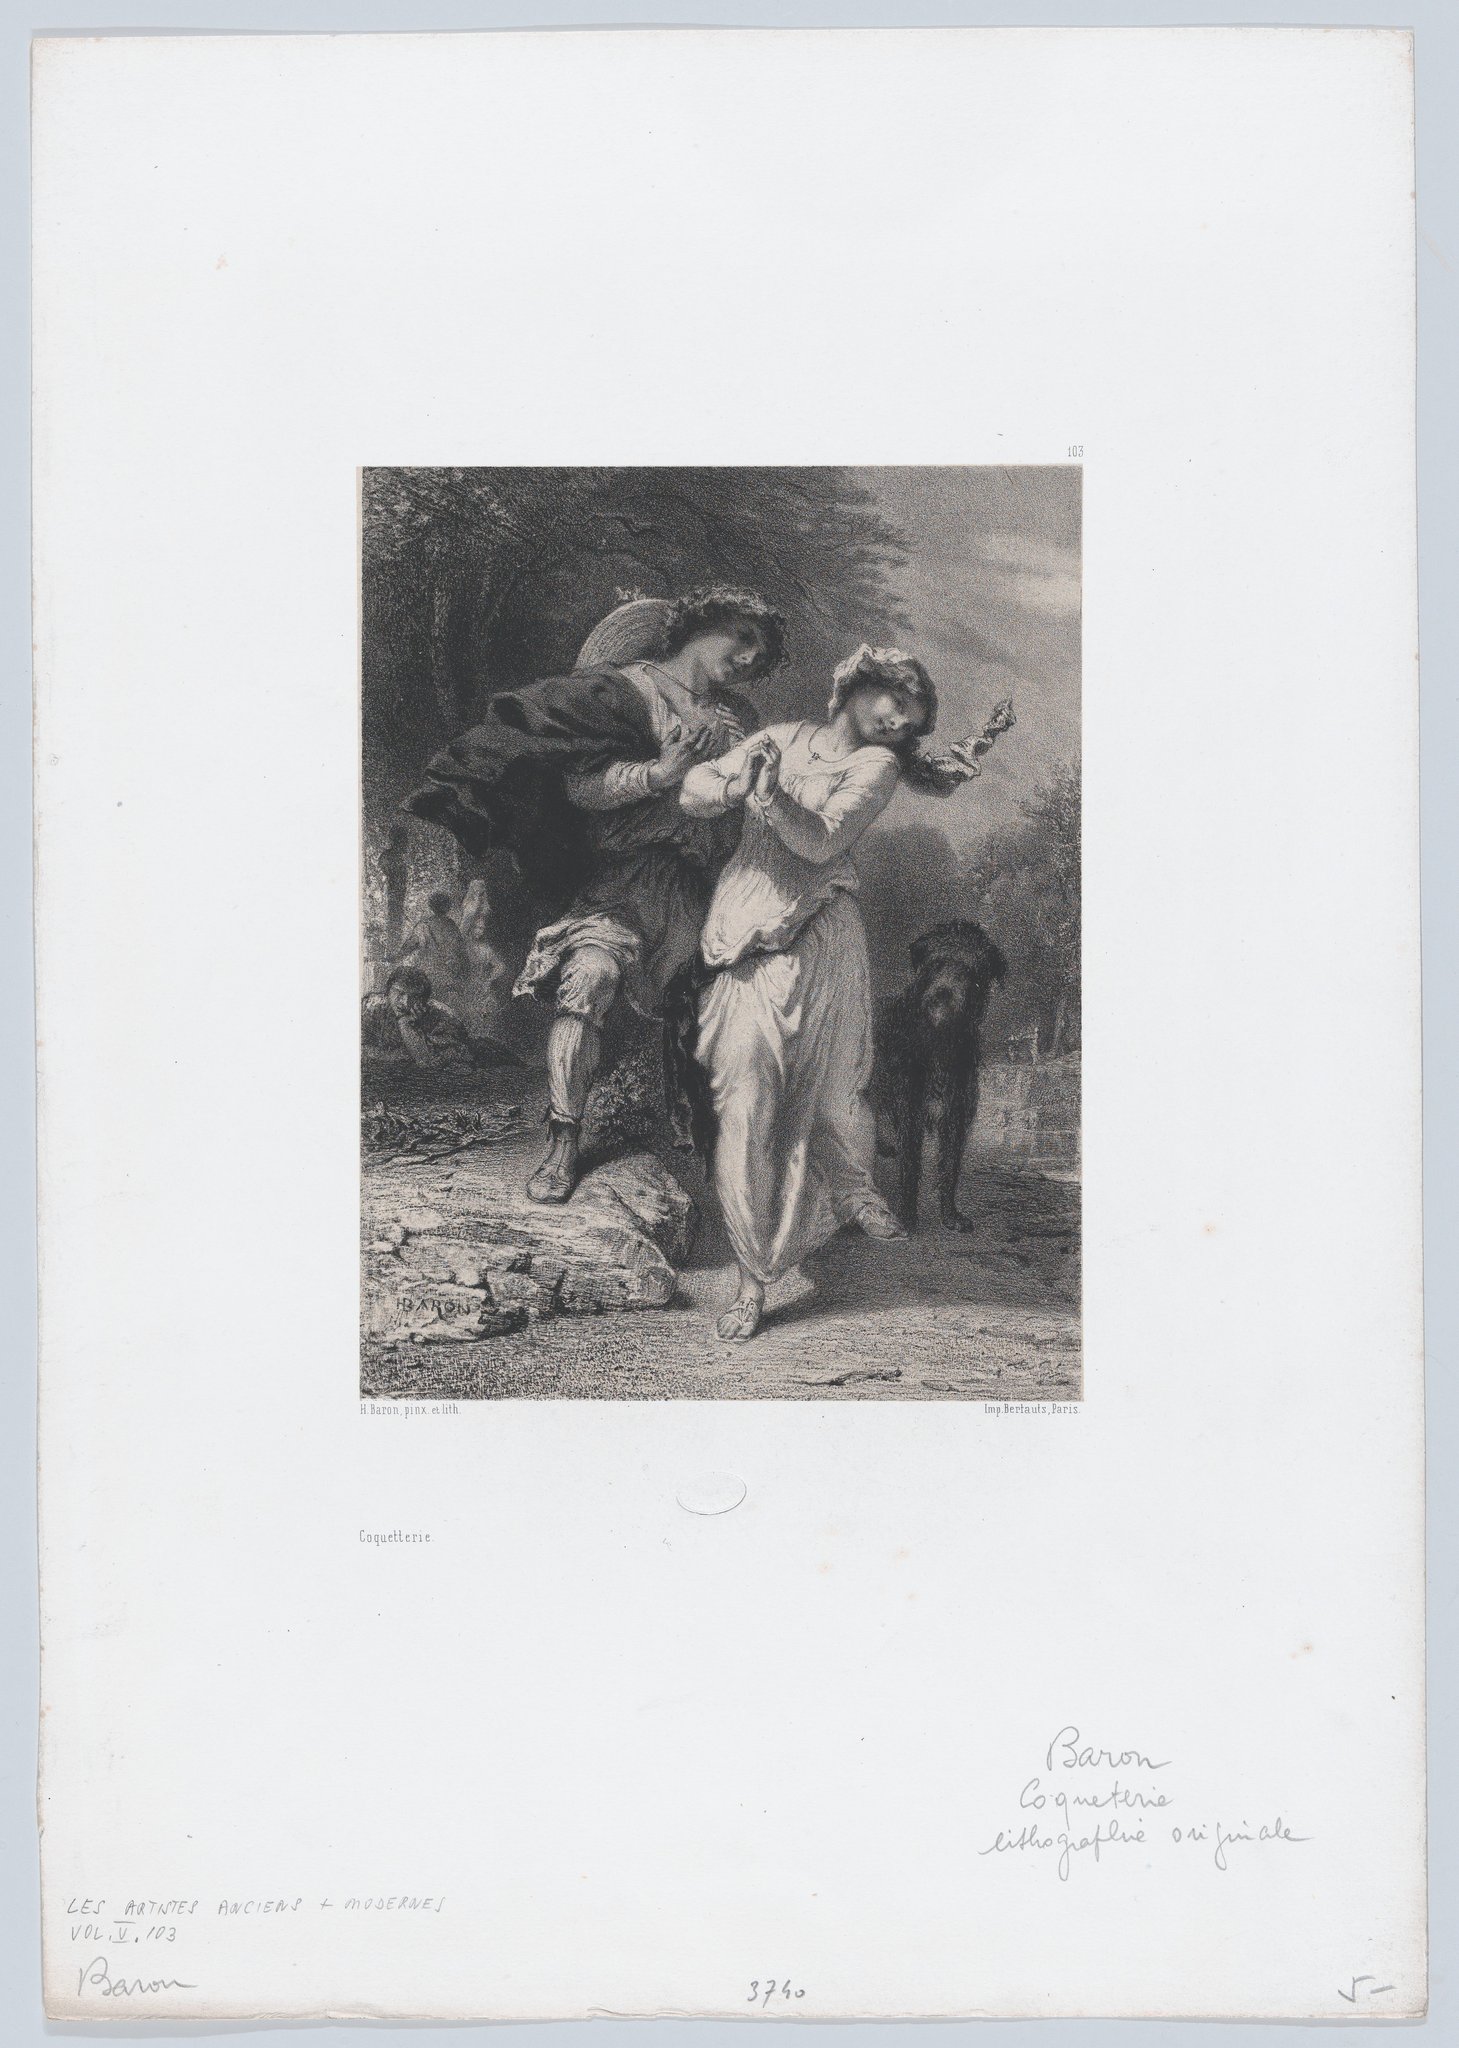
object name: print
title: Flirtatiousness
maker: henri-charles-antoine baron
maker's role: artist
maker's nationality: french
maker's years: 1816-1885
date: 1854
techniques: lithograph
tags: couples,men,women,dogs